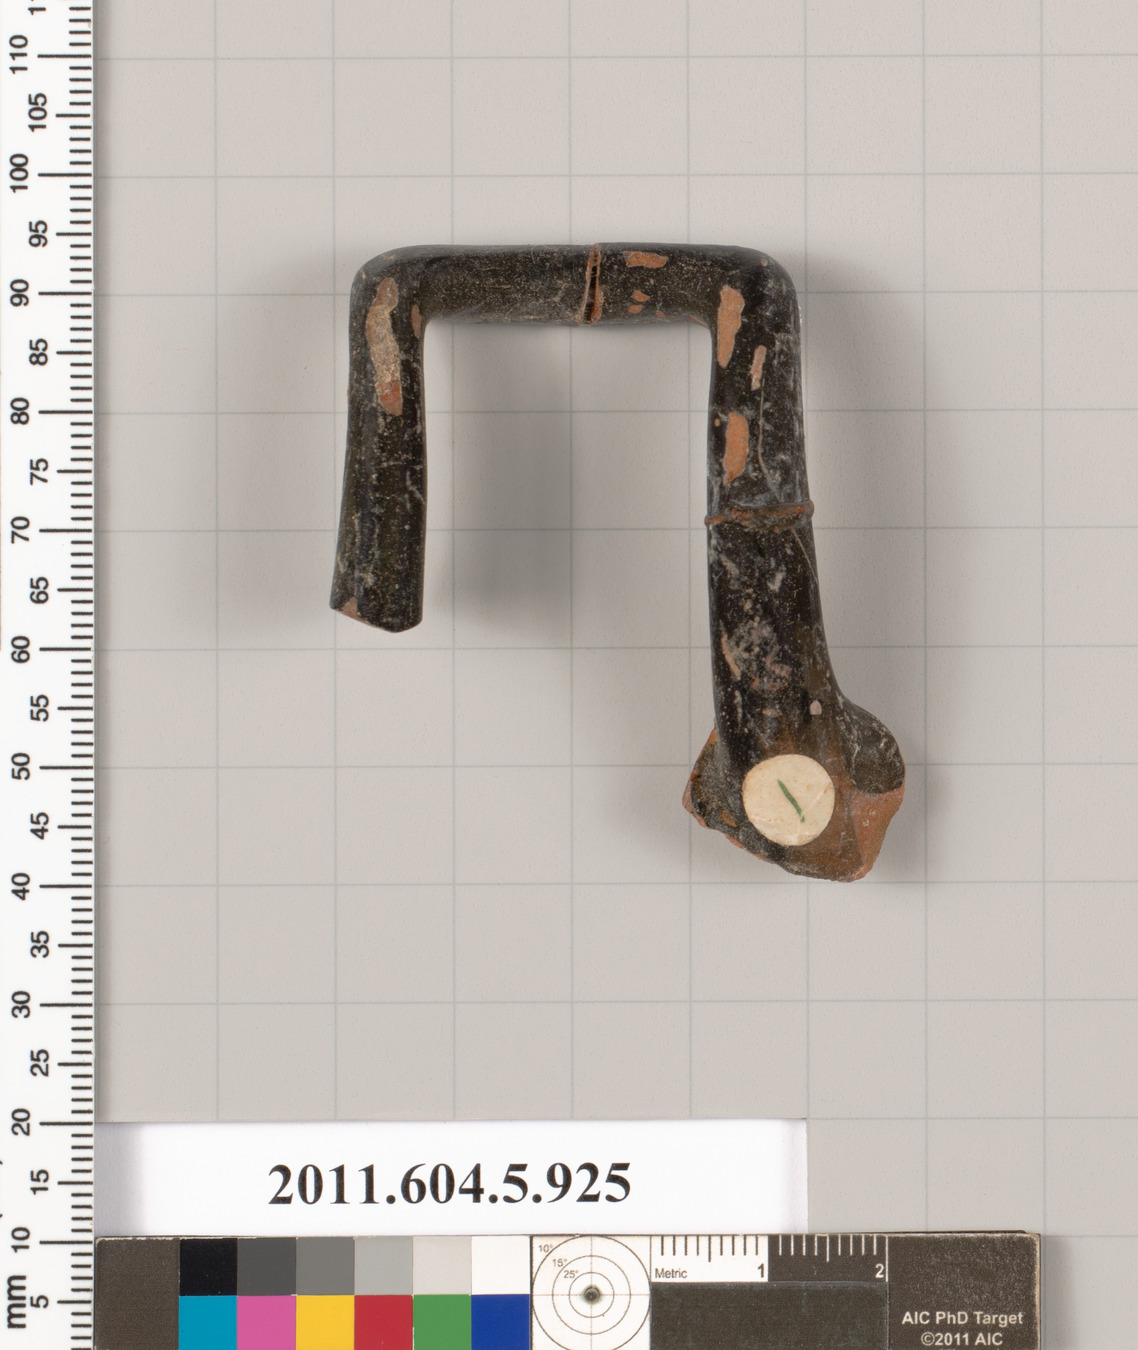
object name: kylix fragment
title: Terracotta fragment of a kylix (drinking cup)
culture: greek, attic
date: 600-401 BCE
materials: terracotta